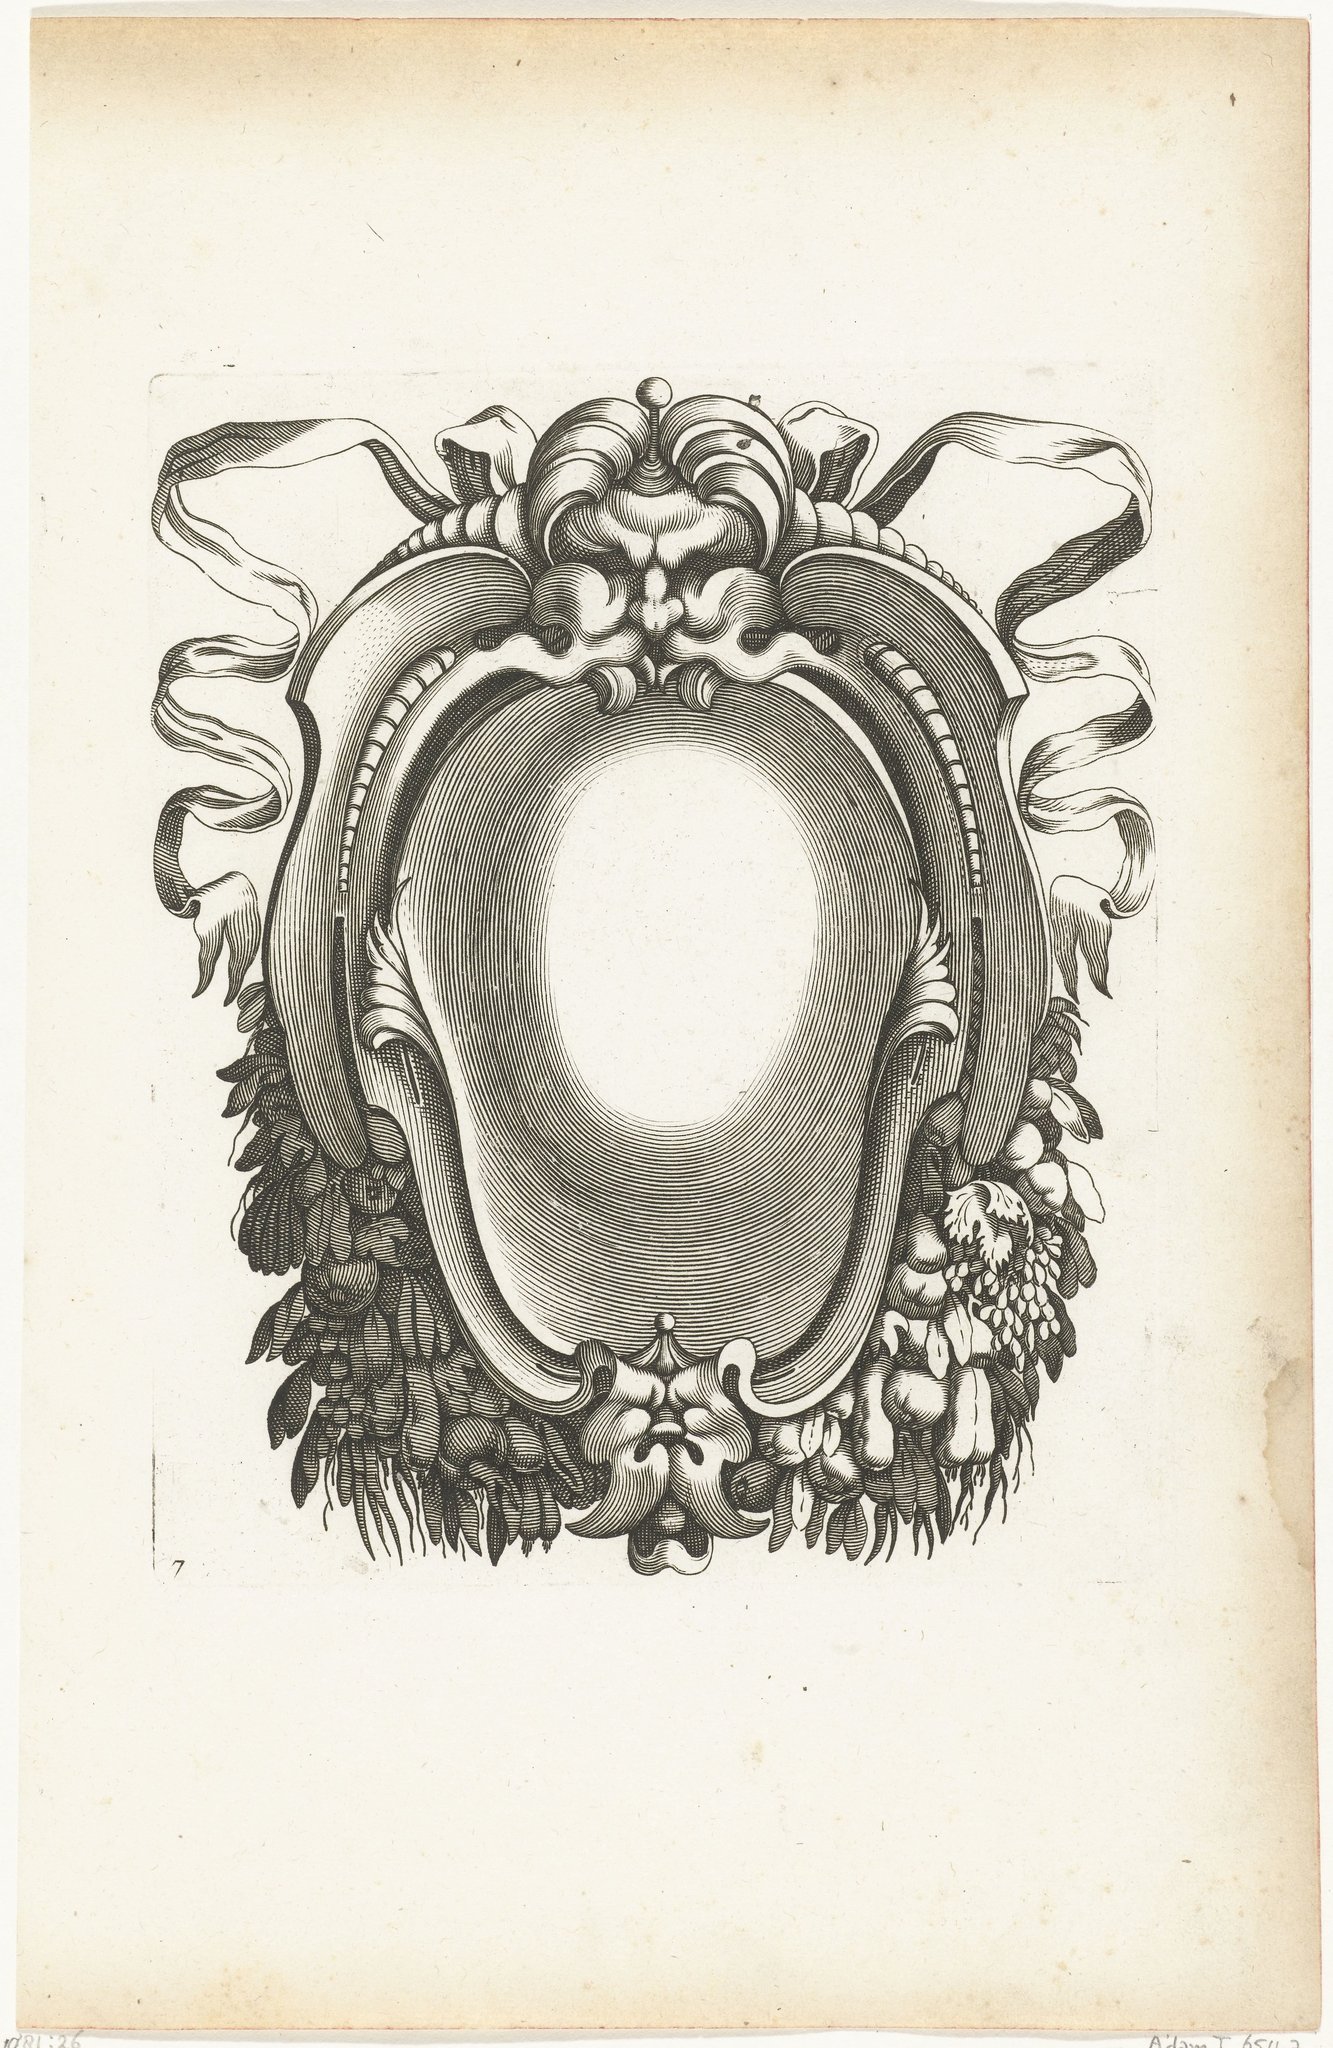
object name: ornament print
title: Cartouches in omlijstingen van rolwerk met grotesken, guirlandes en mascarons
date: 1613-1657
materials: paper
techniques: engraving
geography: france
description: Midden boven hangt een mascaron met een knop op het hoofd en linten achter zich.